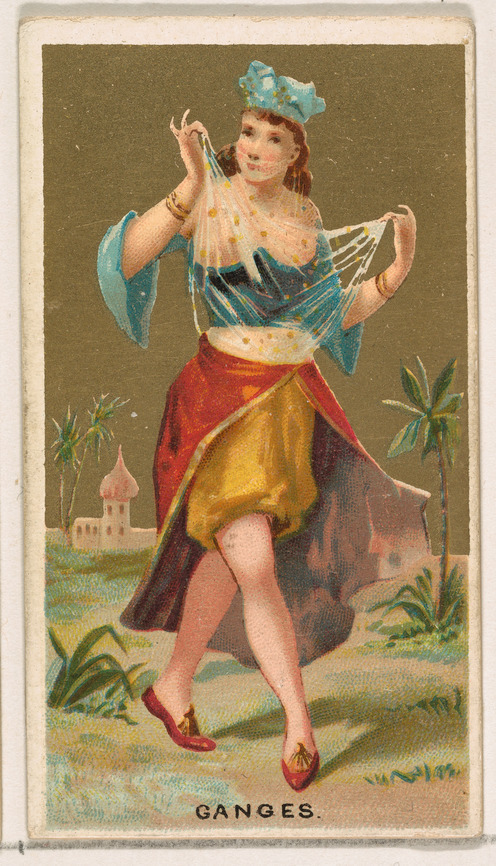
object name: print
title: Ganges, from the Dancing Girls of the World series (N185) issued by Wm. S. Kimball & Co.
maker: william s. kimball & company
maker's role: publisher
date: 1889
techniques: color lithograph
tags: women,dancing,dancers